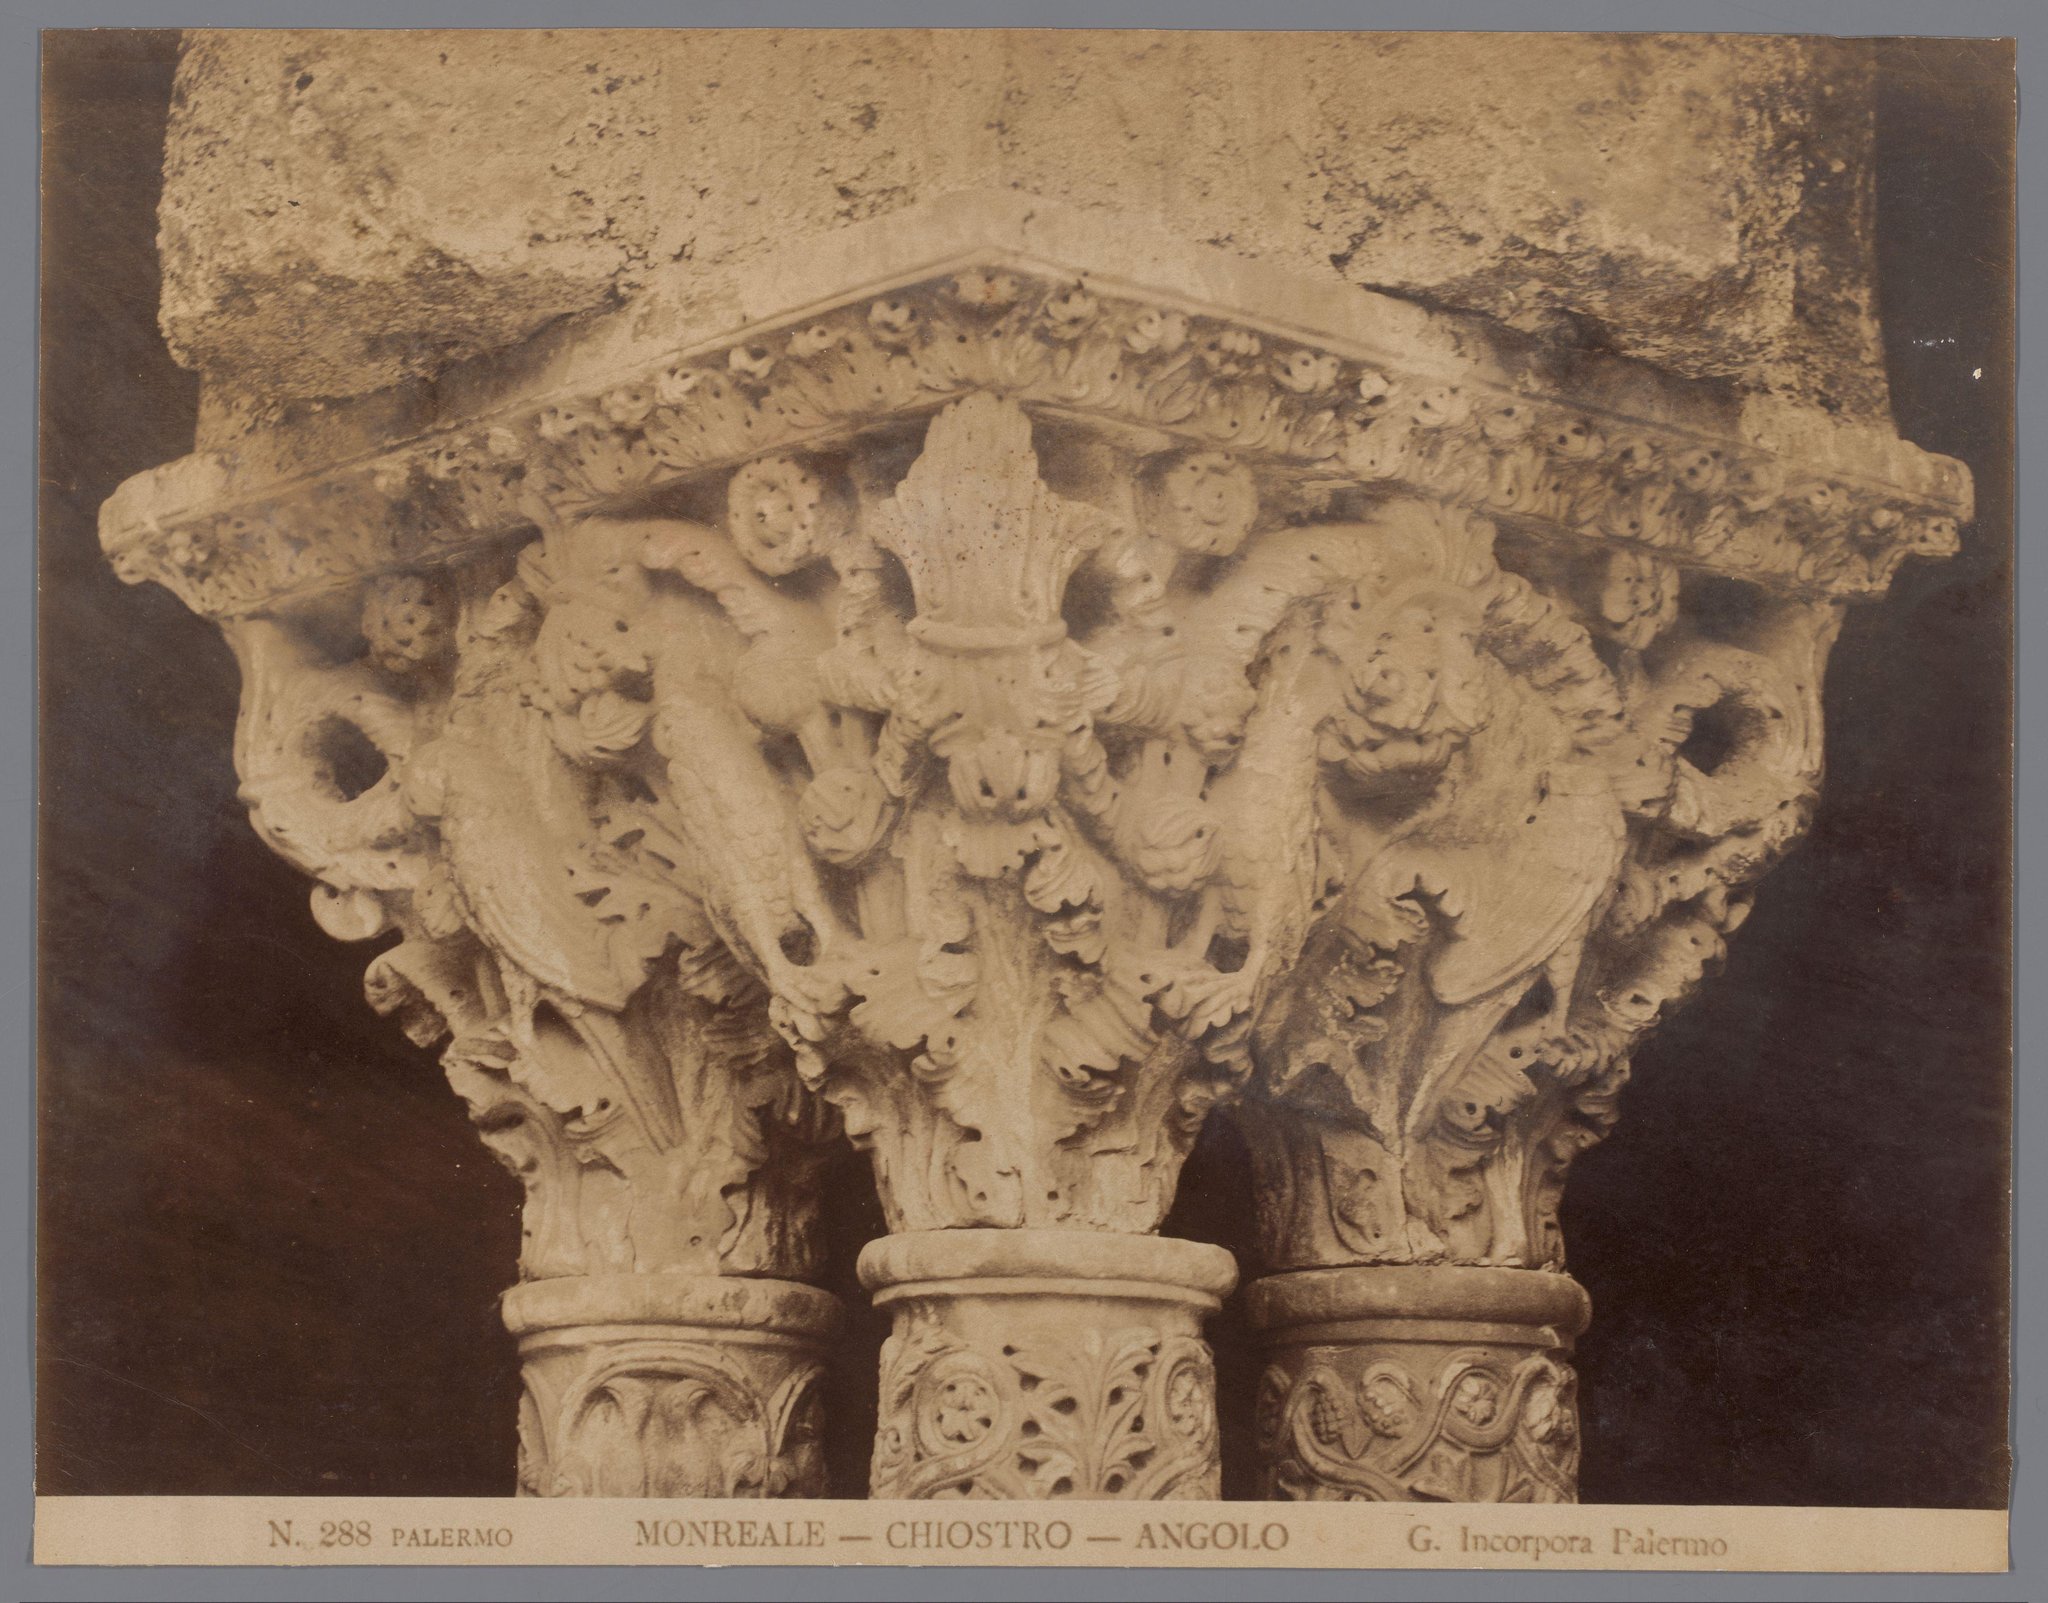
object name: photograph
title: Monreale, Chiostro, angolo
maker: giuseppe incorpora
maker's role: fotograaf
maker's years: 1834-1914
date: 1856-1914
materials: paper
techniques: albumen print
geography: monreale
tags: abbey, monastery, convent ~ roman catholic church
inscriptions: number: ‘N. 288’